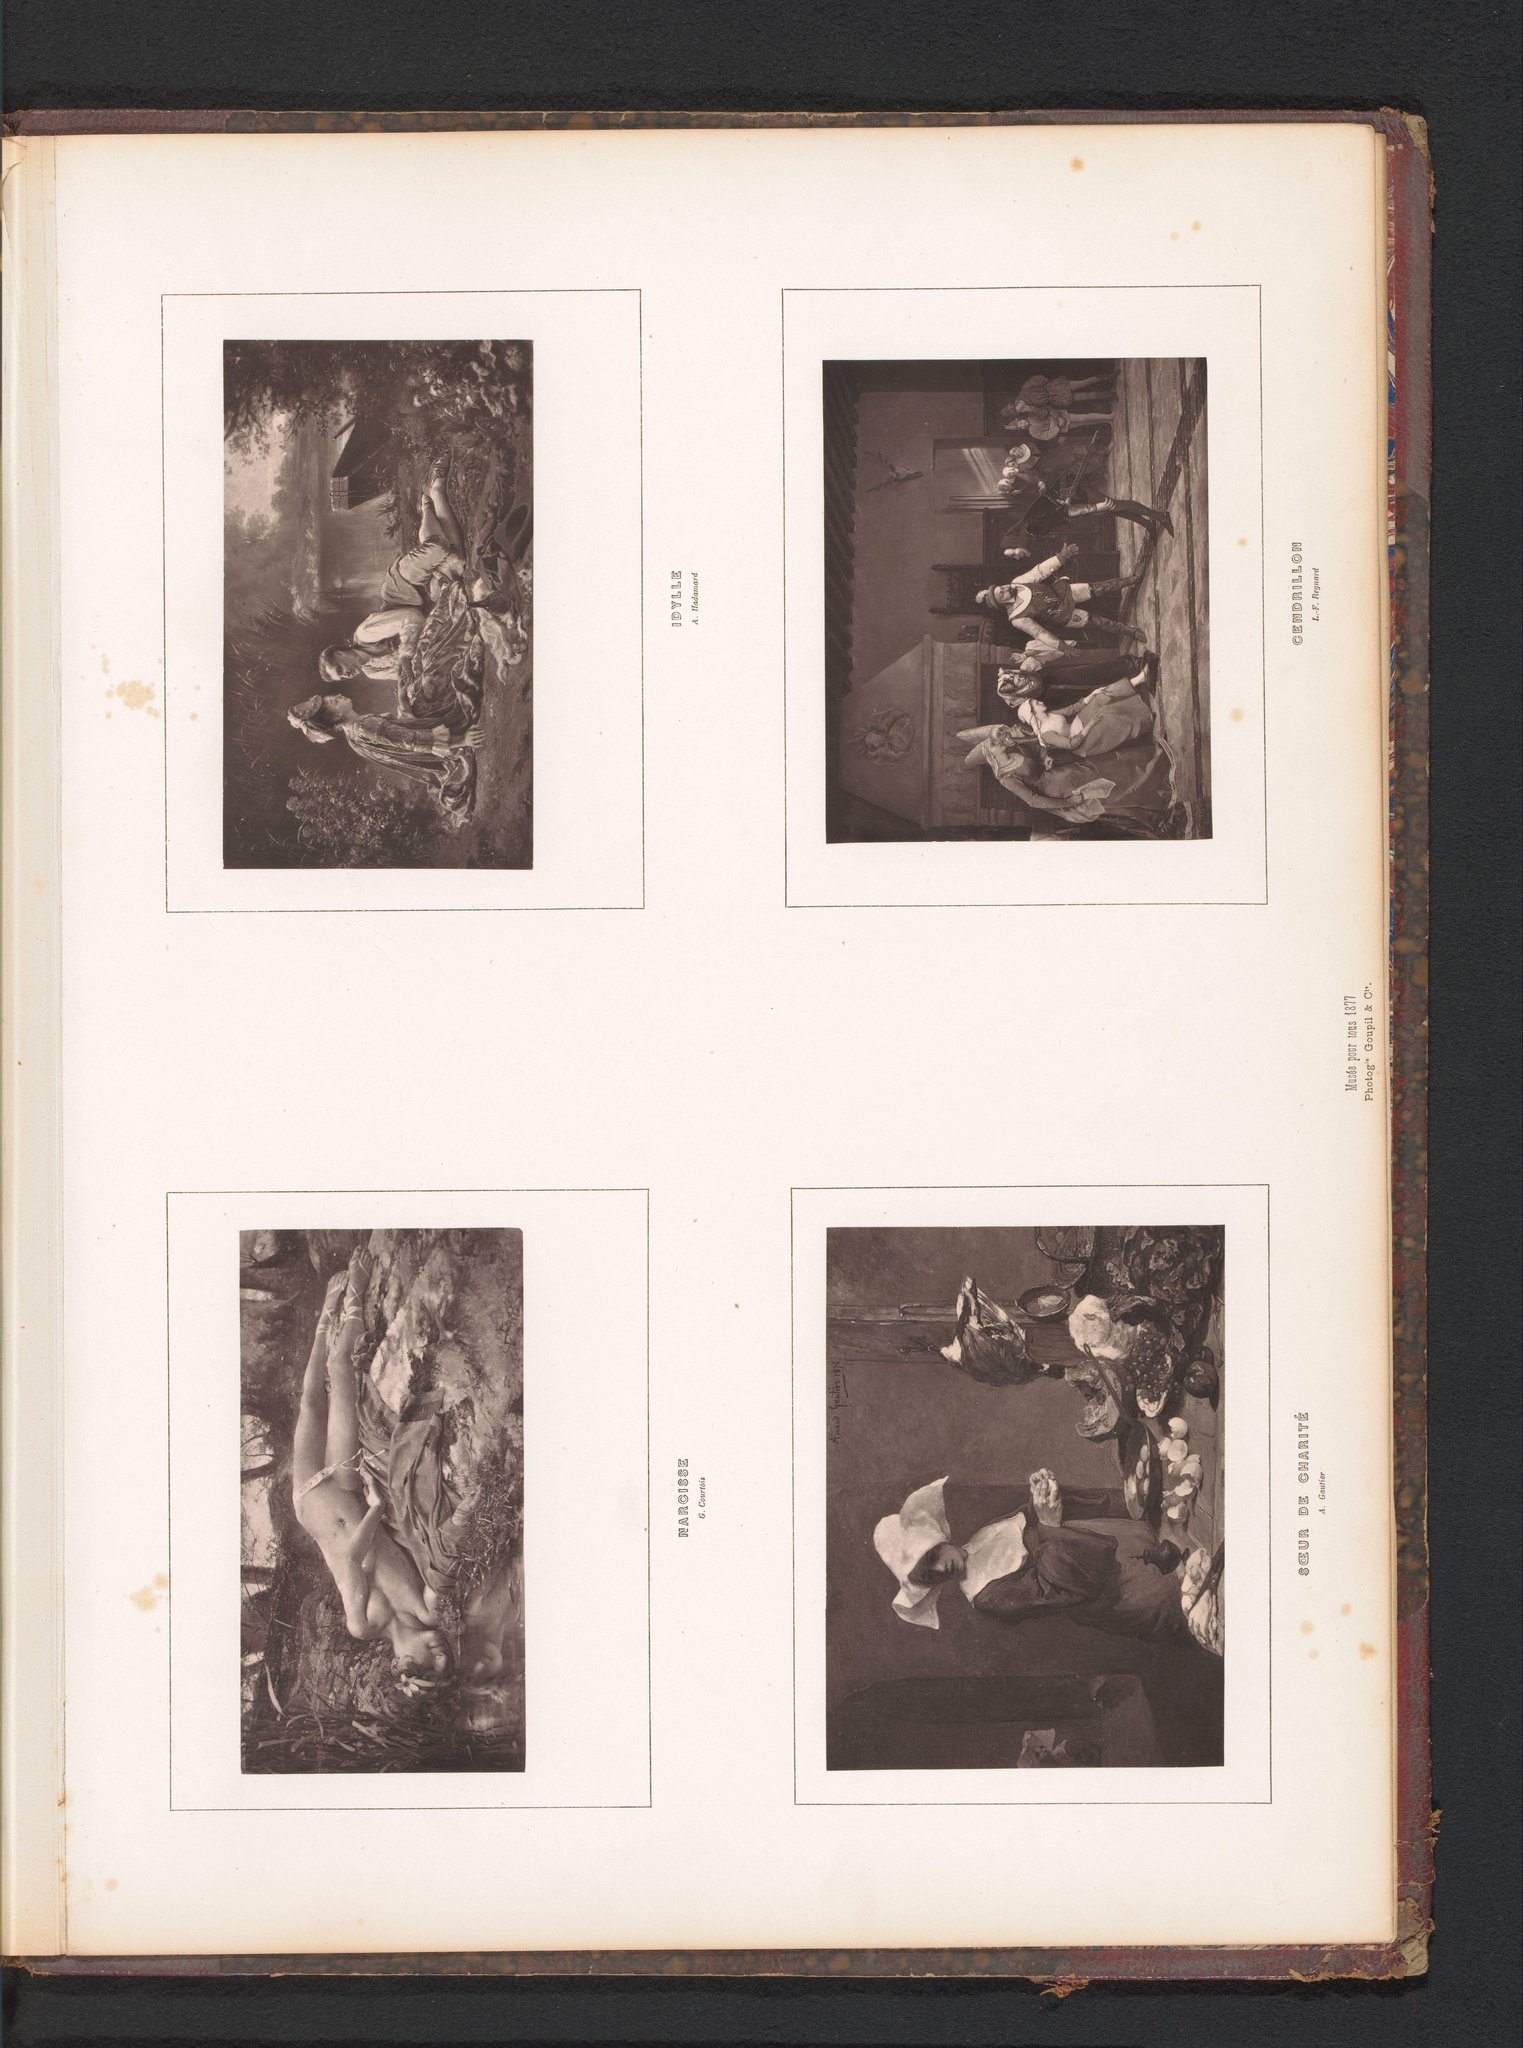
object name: page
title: Narcisse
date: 1872-1879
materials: paper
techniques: woodburytype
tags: charity, 'caritas'; 'carità' (ripa) ~ one of the three theological virtues, suffering, misfortune of narcissus, tales and fairy tales (with title), pastorals, arcadian scenes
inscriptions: inscription: ‘Musée pour tous 1877’